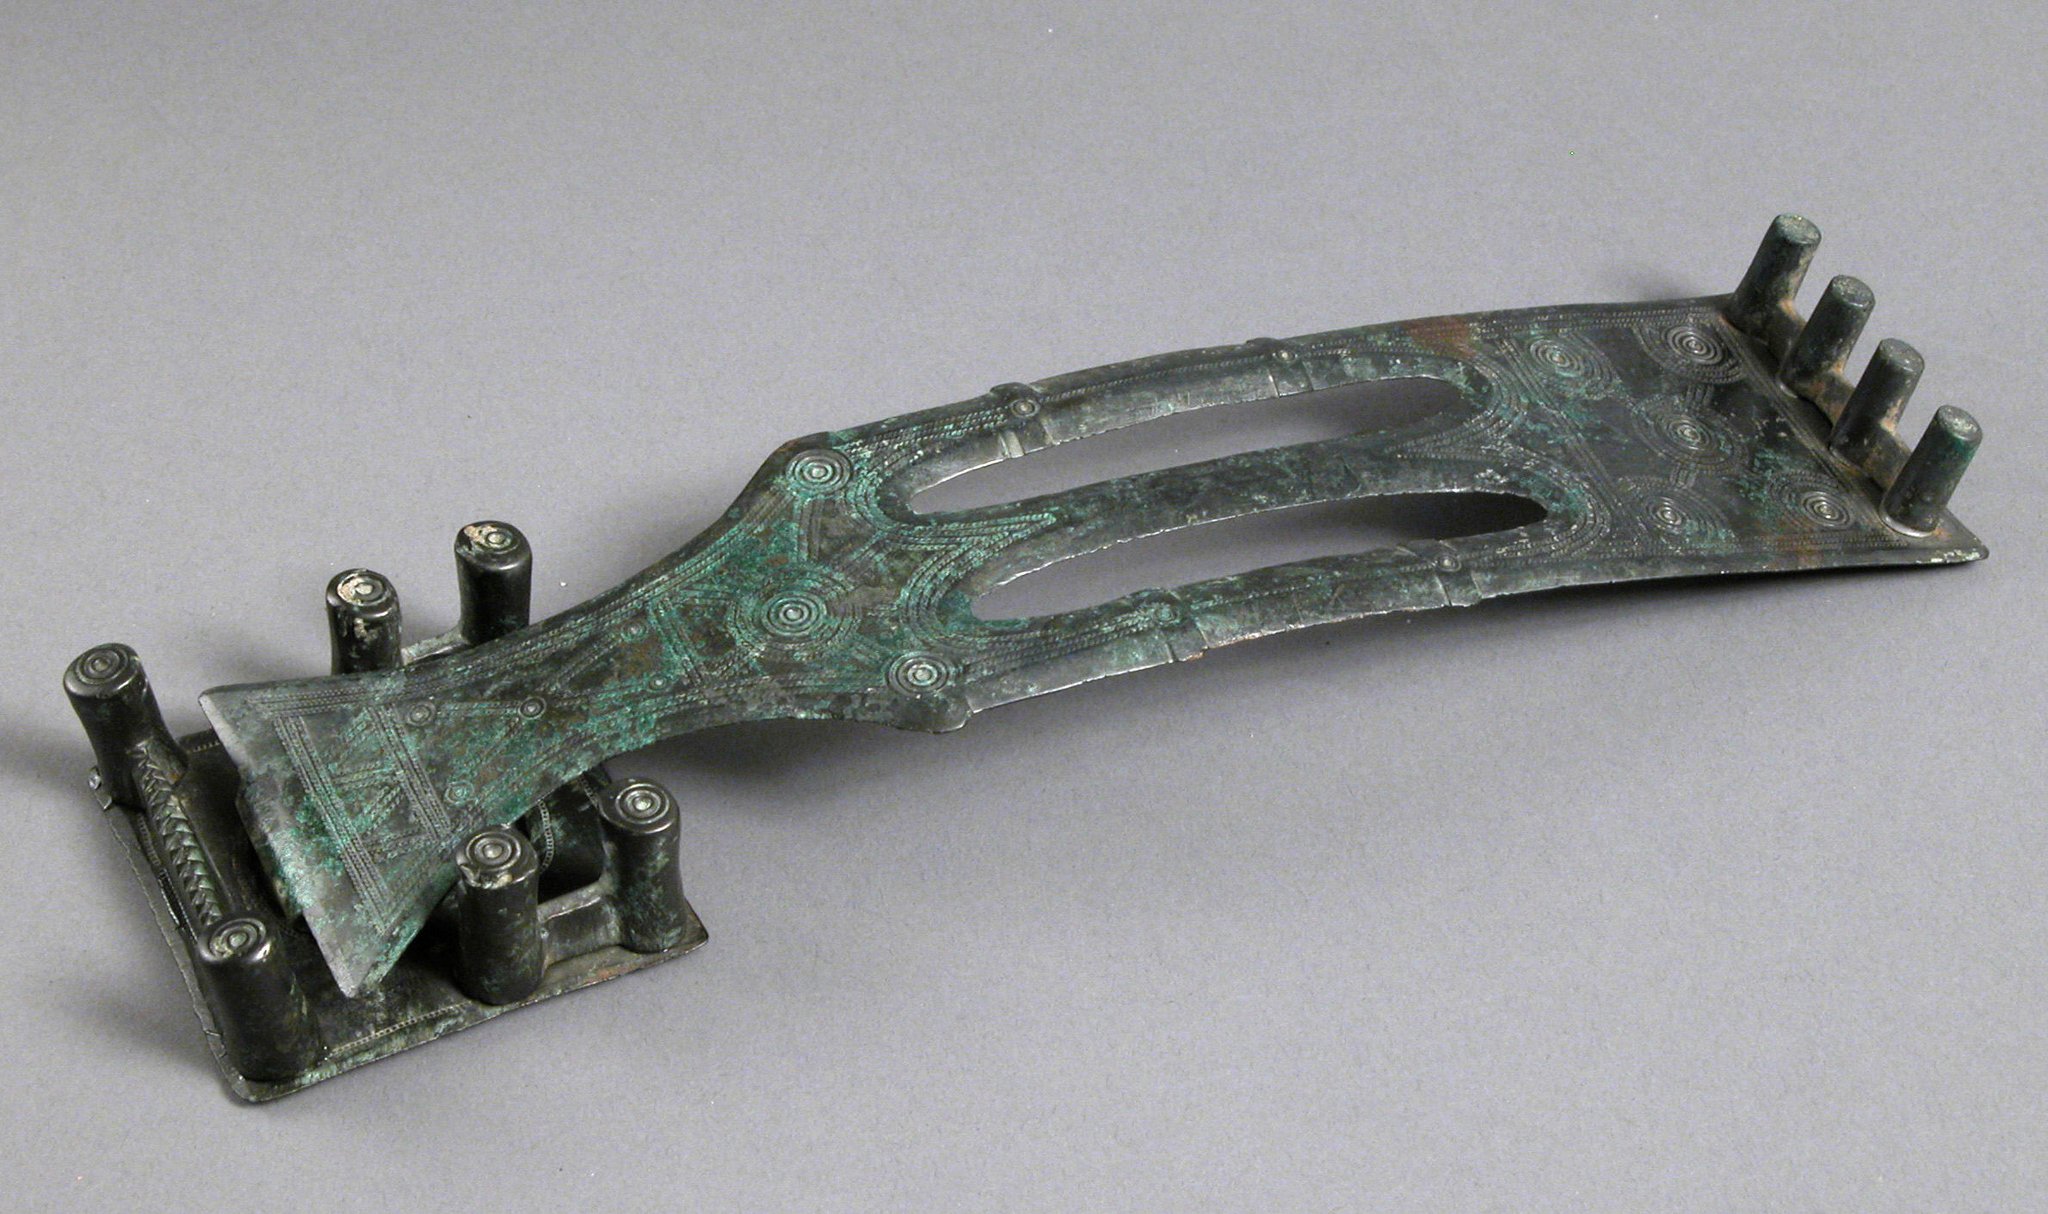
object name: buckle plate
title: Buckle and Plate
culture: celto-iberian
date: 500-401 BCE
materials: copper alloy